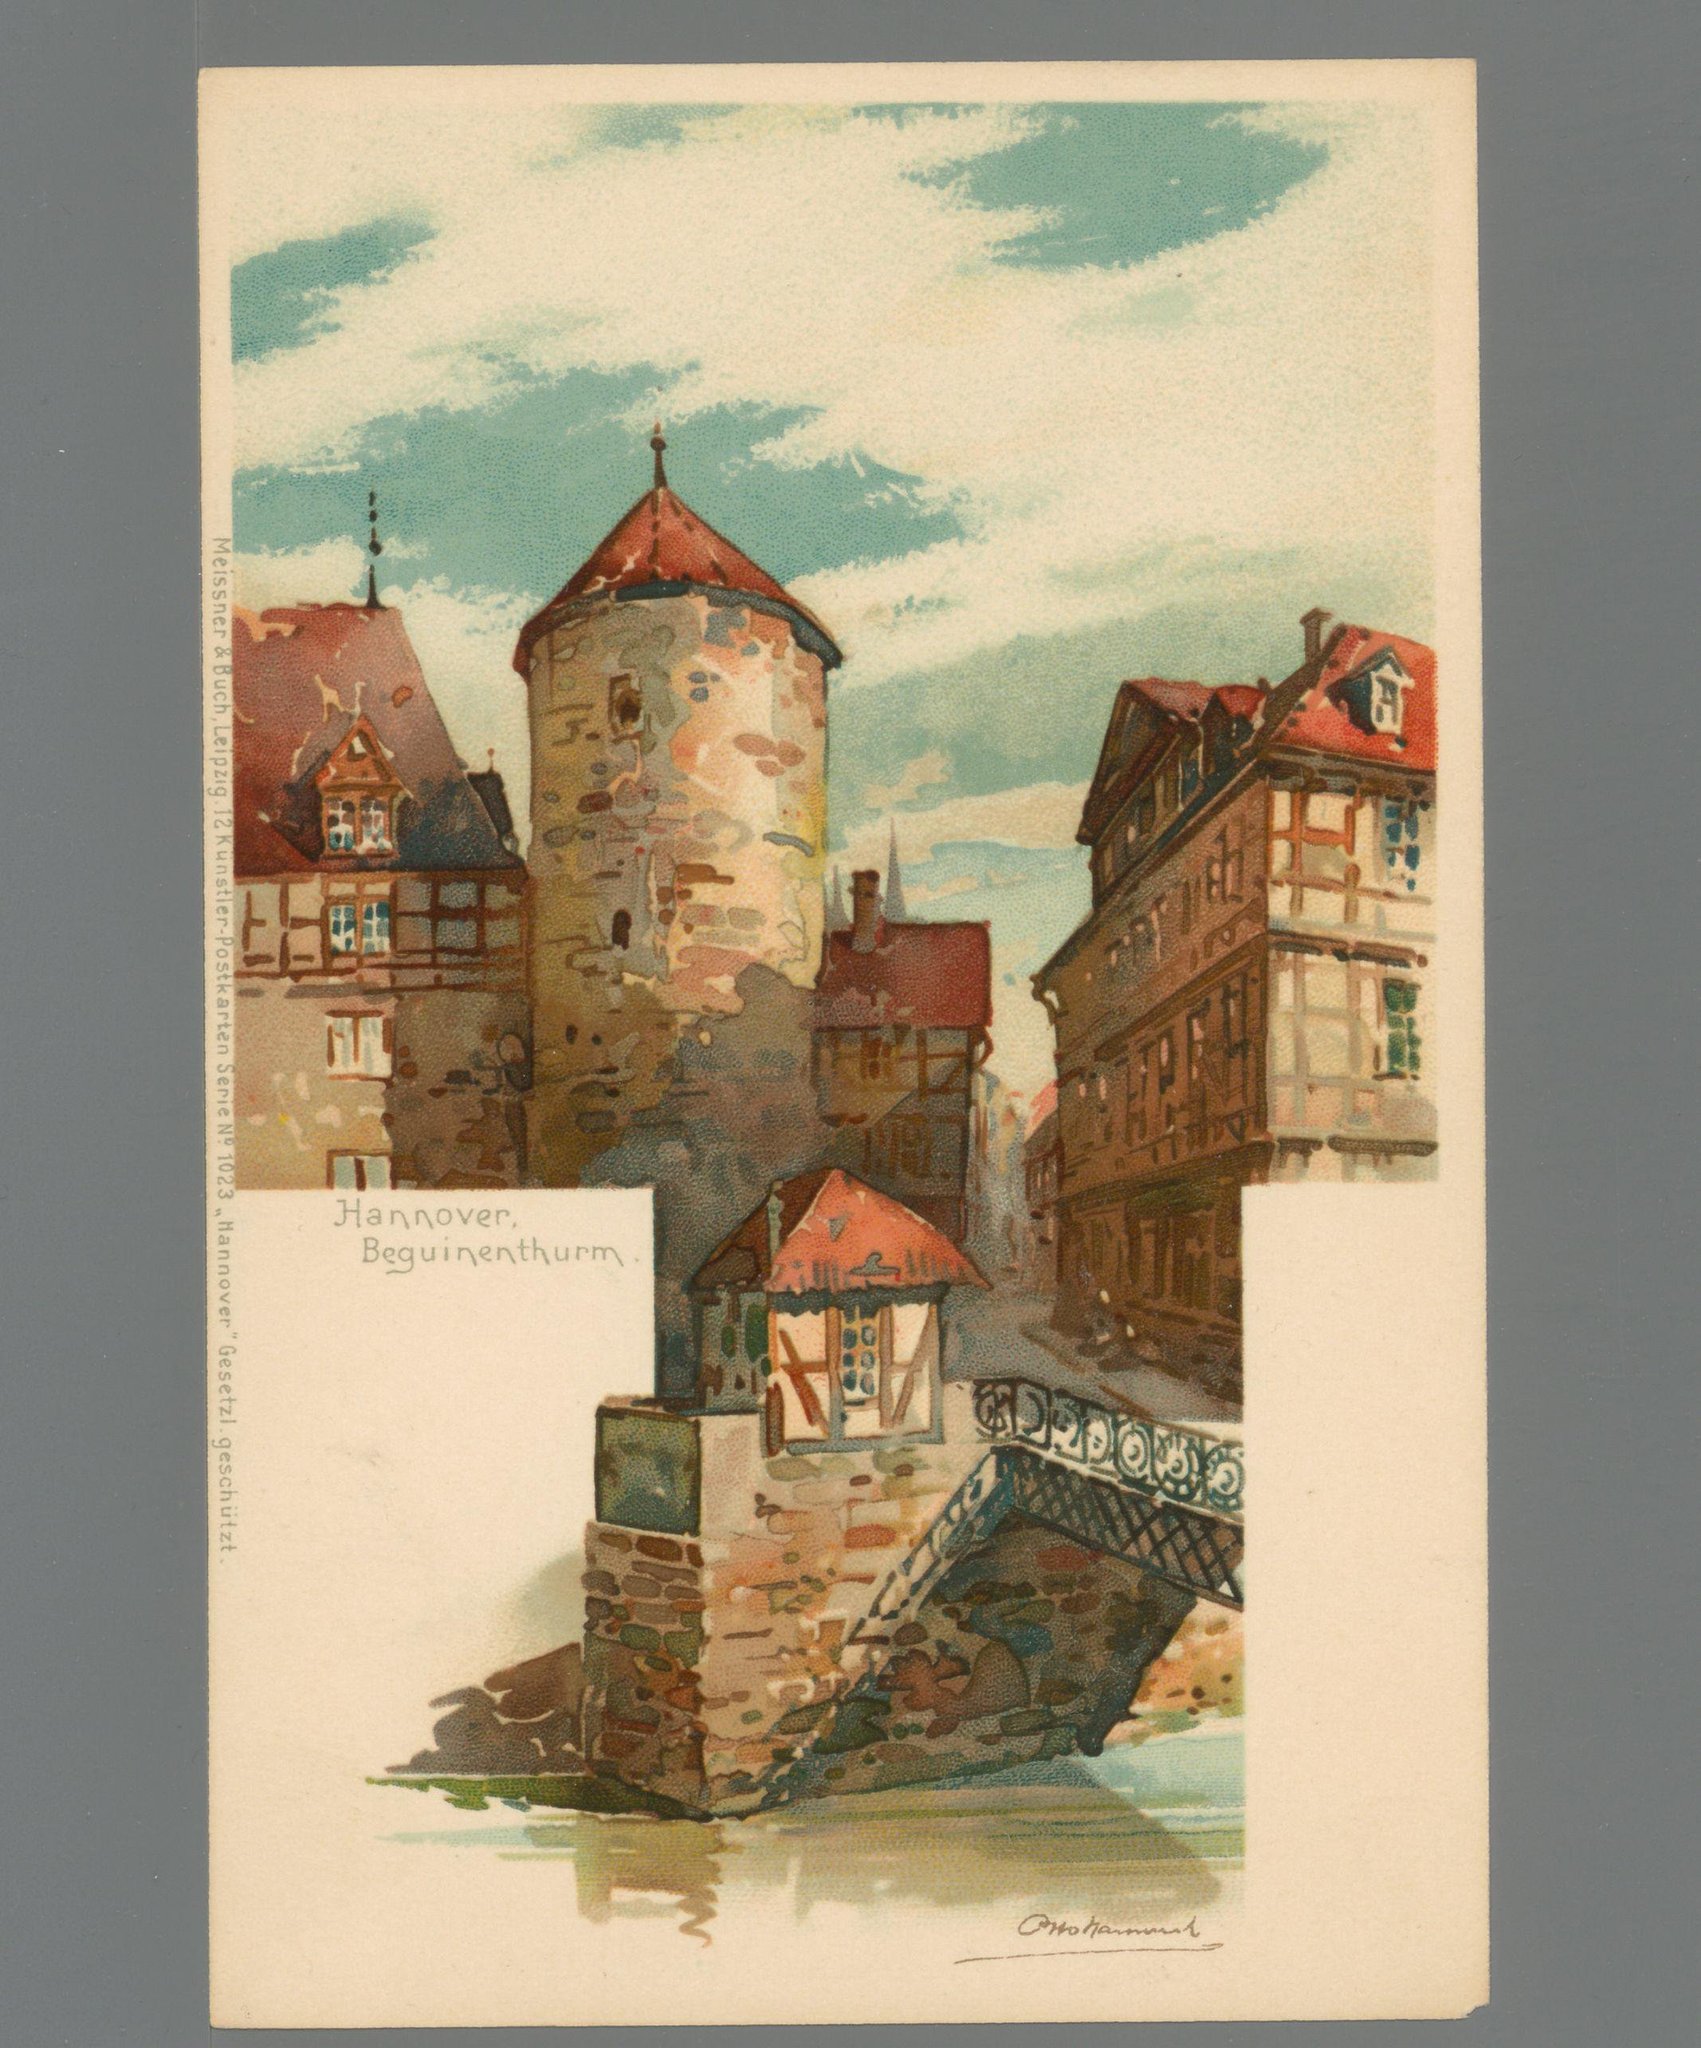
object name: reproduction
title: Hannover, Beguinenthurm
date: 1905-1930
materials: cardboard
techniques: lithograph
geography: leipzig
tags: towers ~ fortified city, canals, waters (in city)